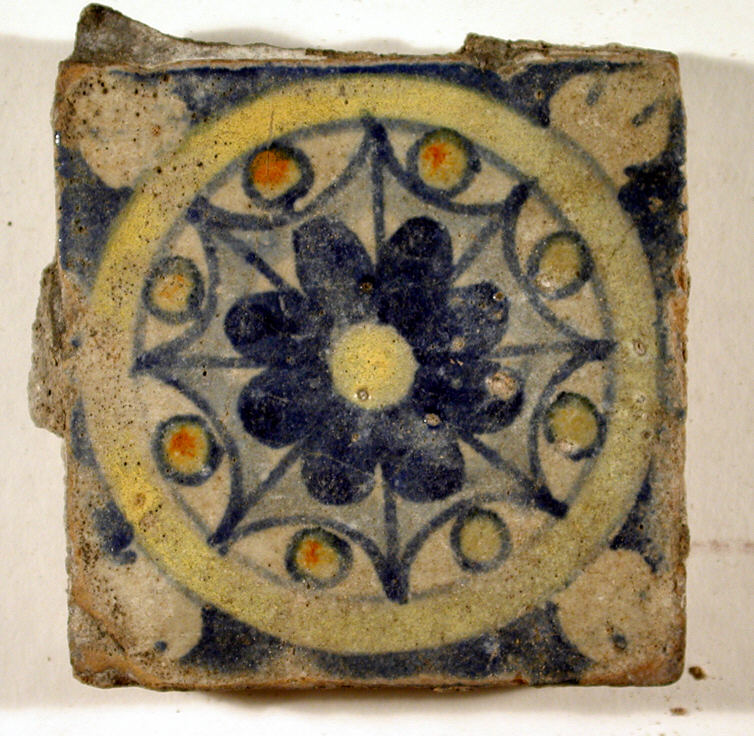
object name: pavement tile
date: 1501-1700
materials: earthenware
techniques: glazing